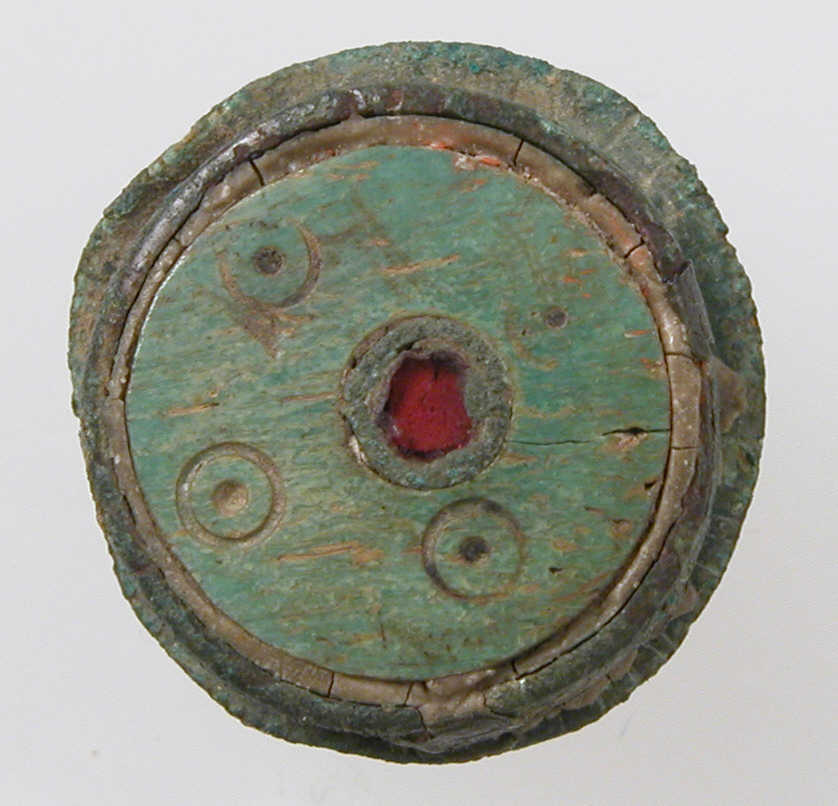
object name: button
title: Flat Circular Button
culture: roman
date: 601-700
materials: copper alloy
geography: northern france